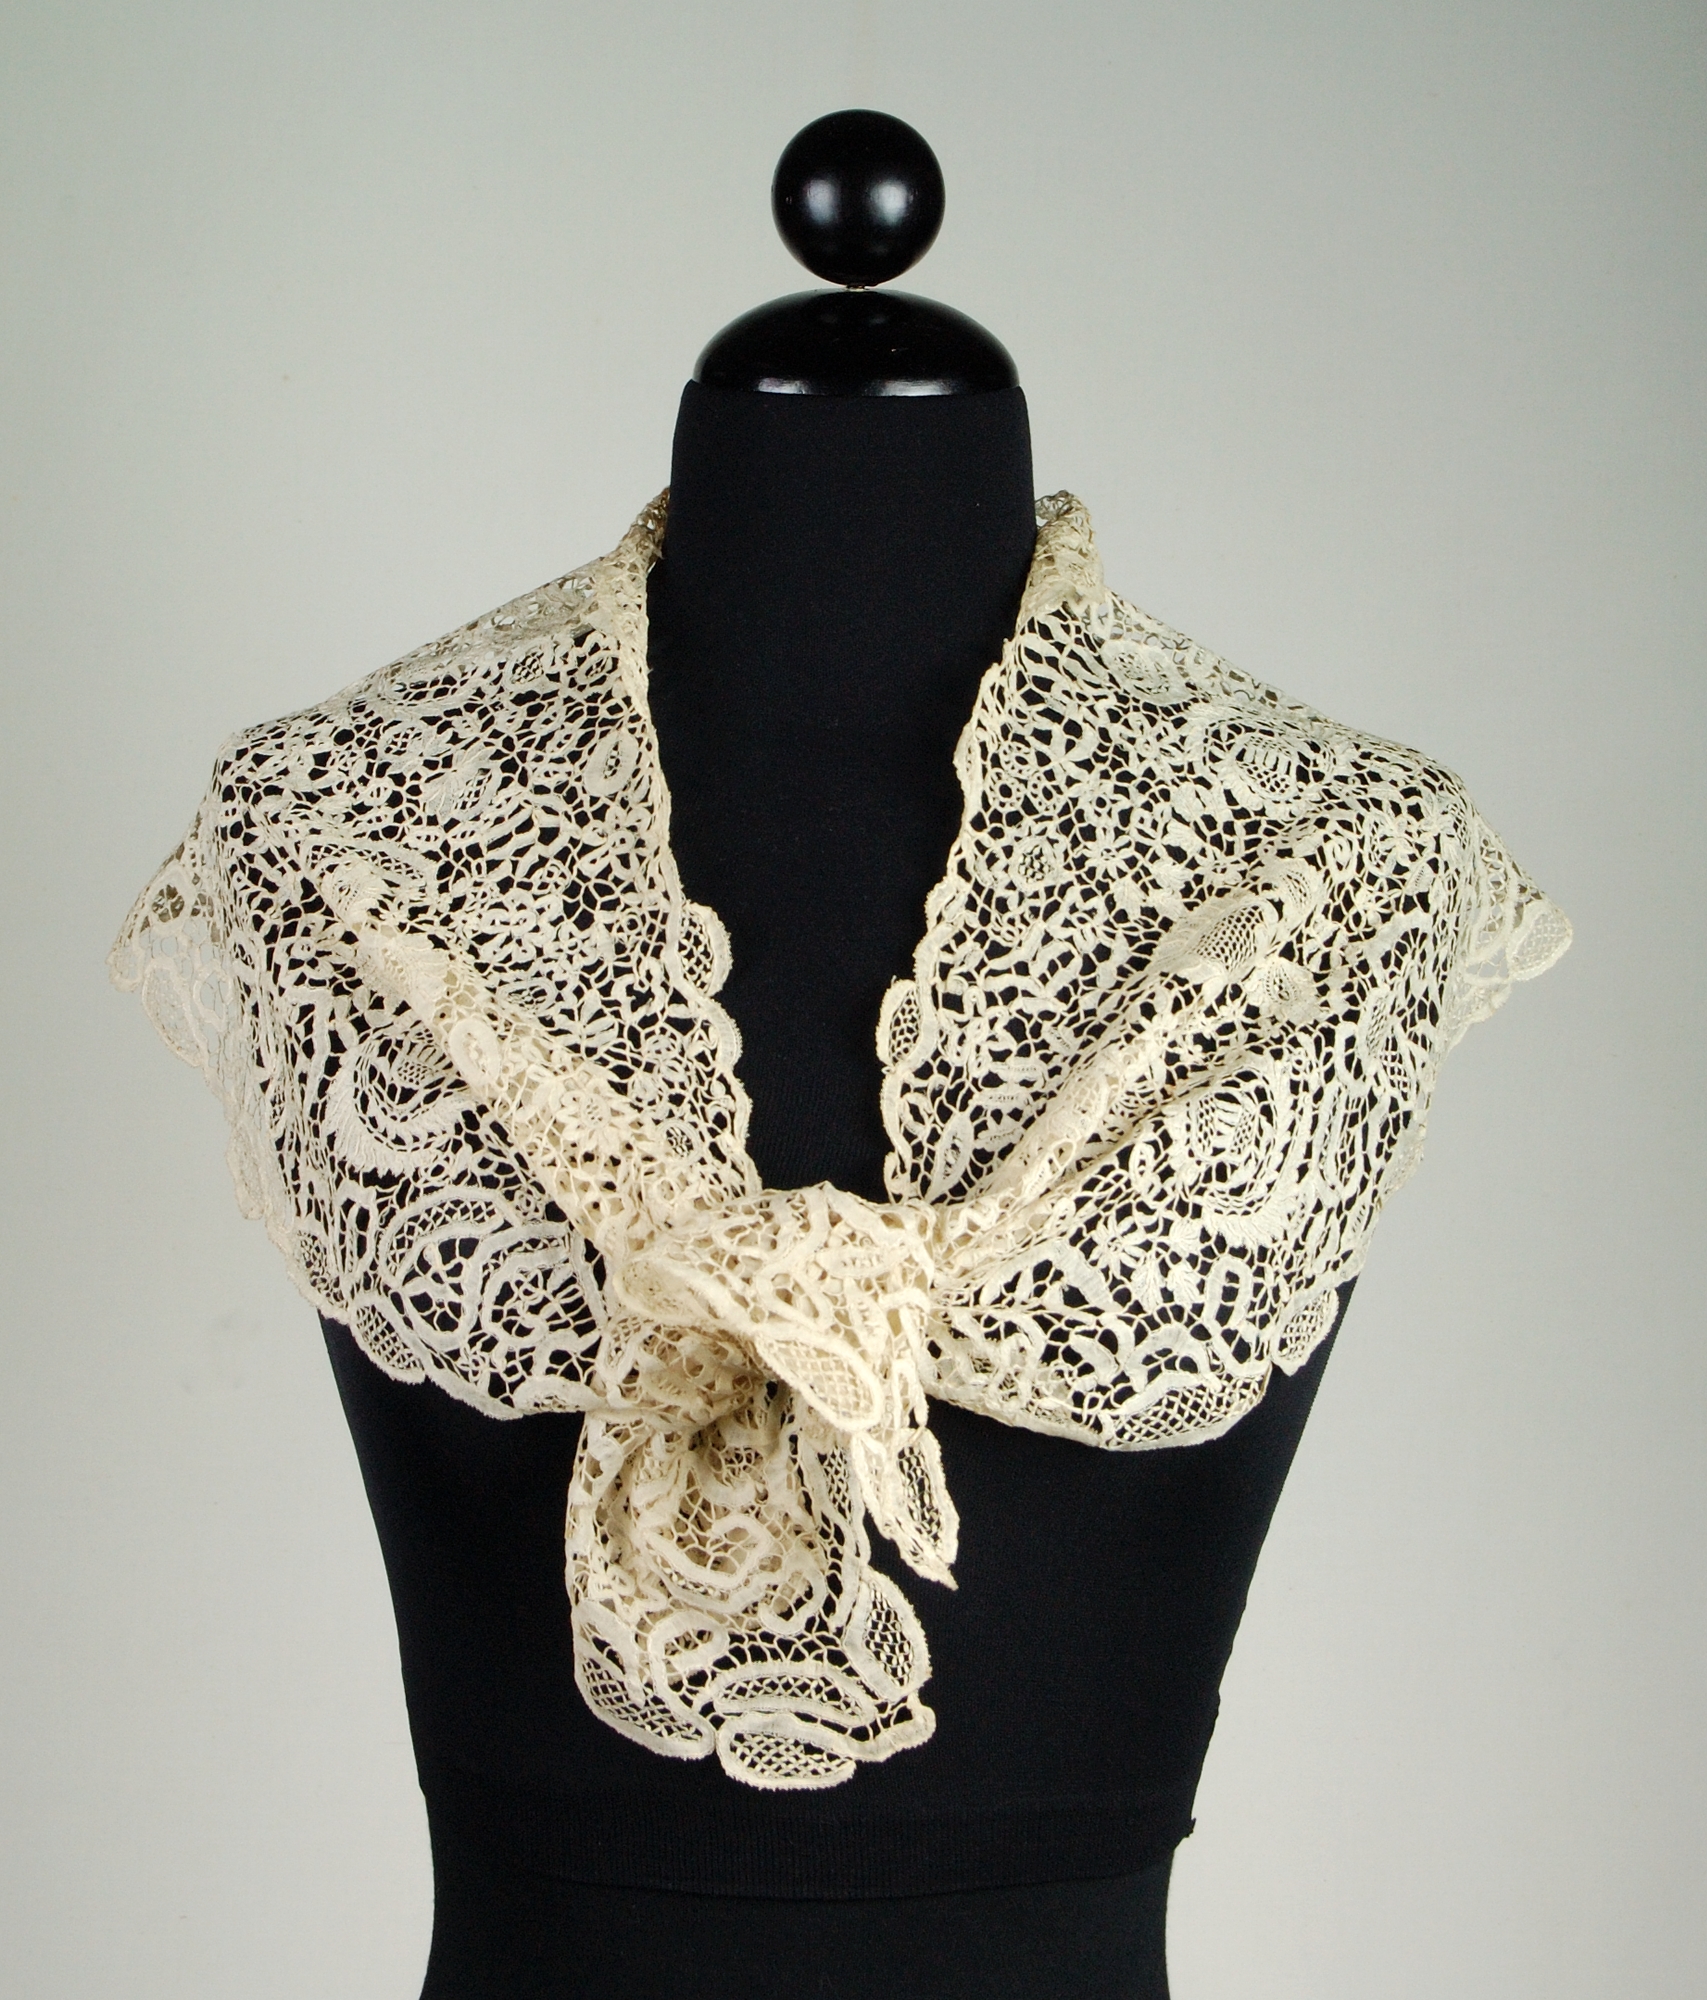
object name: fichu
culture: british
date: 1850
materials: linen